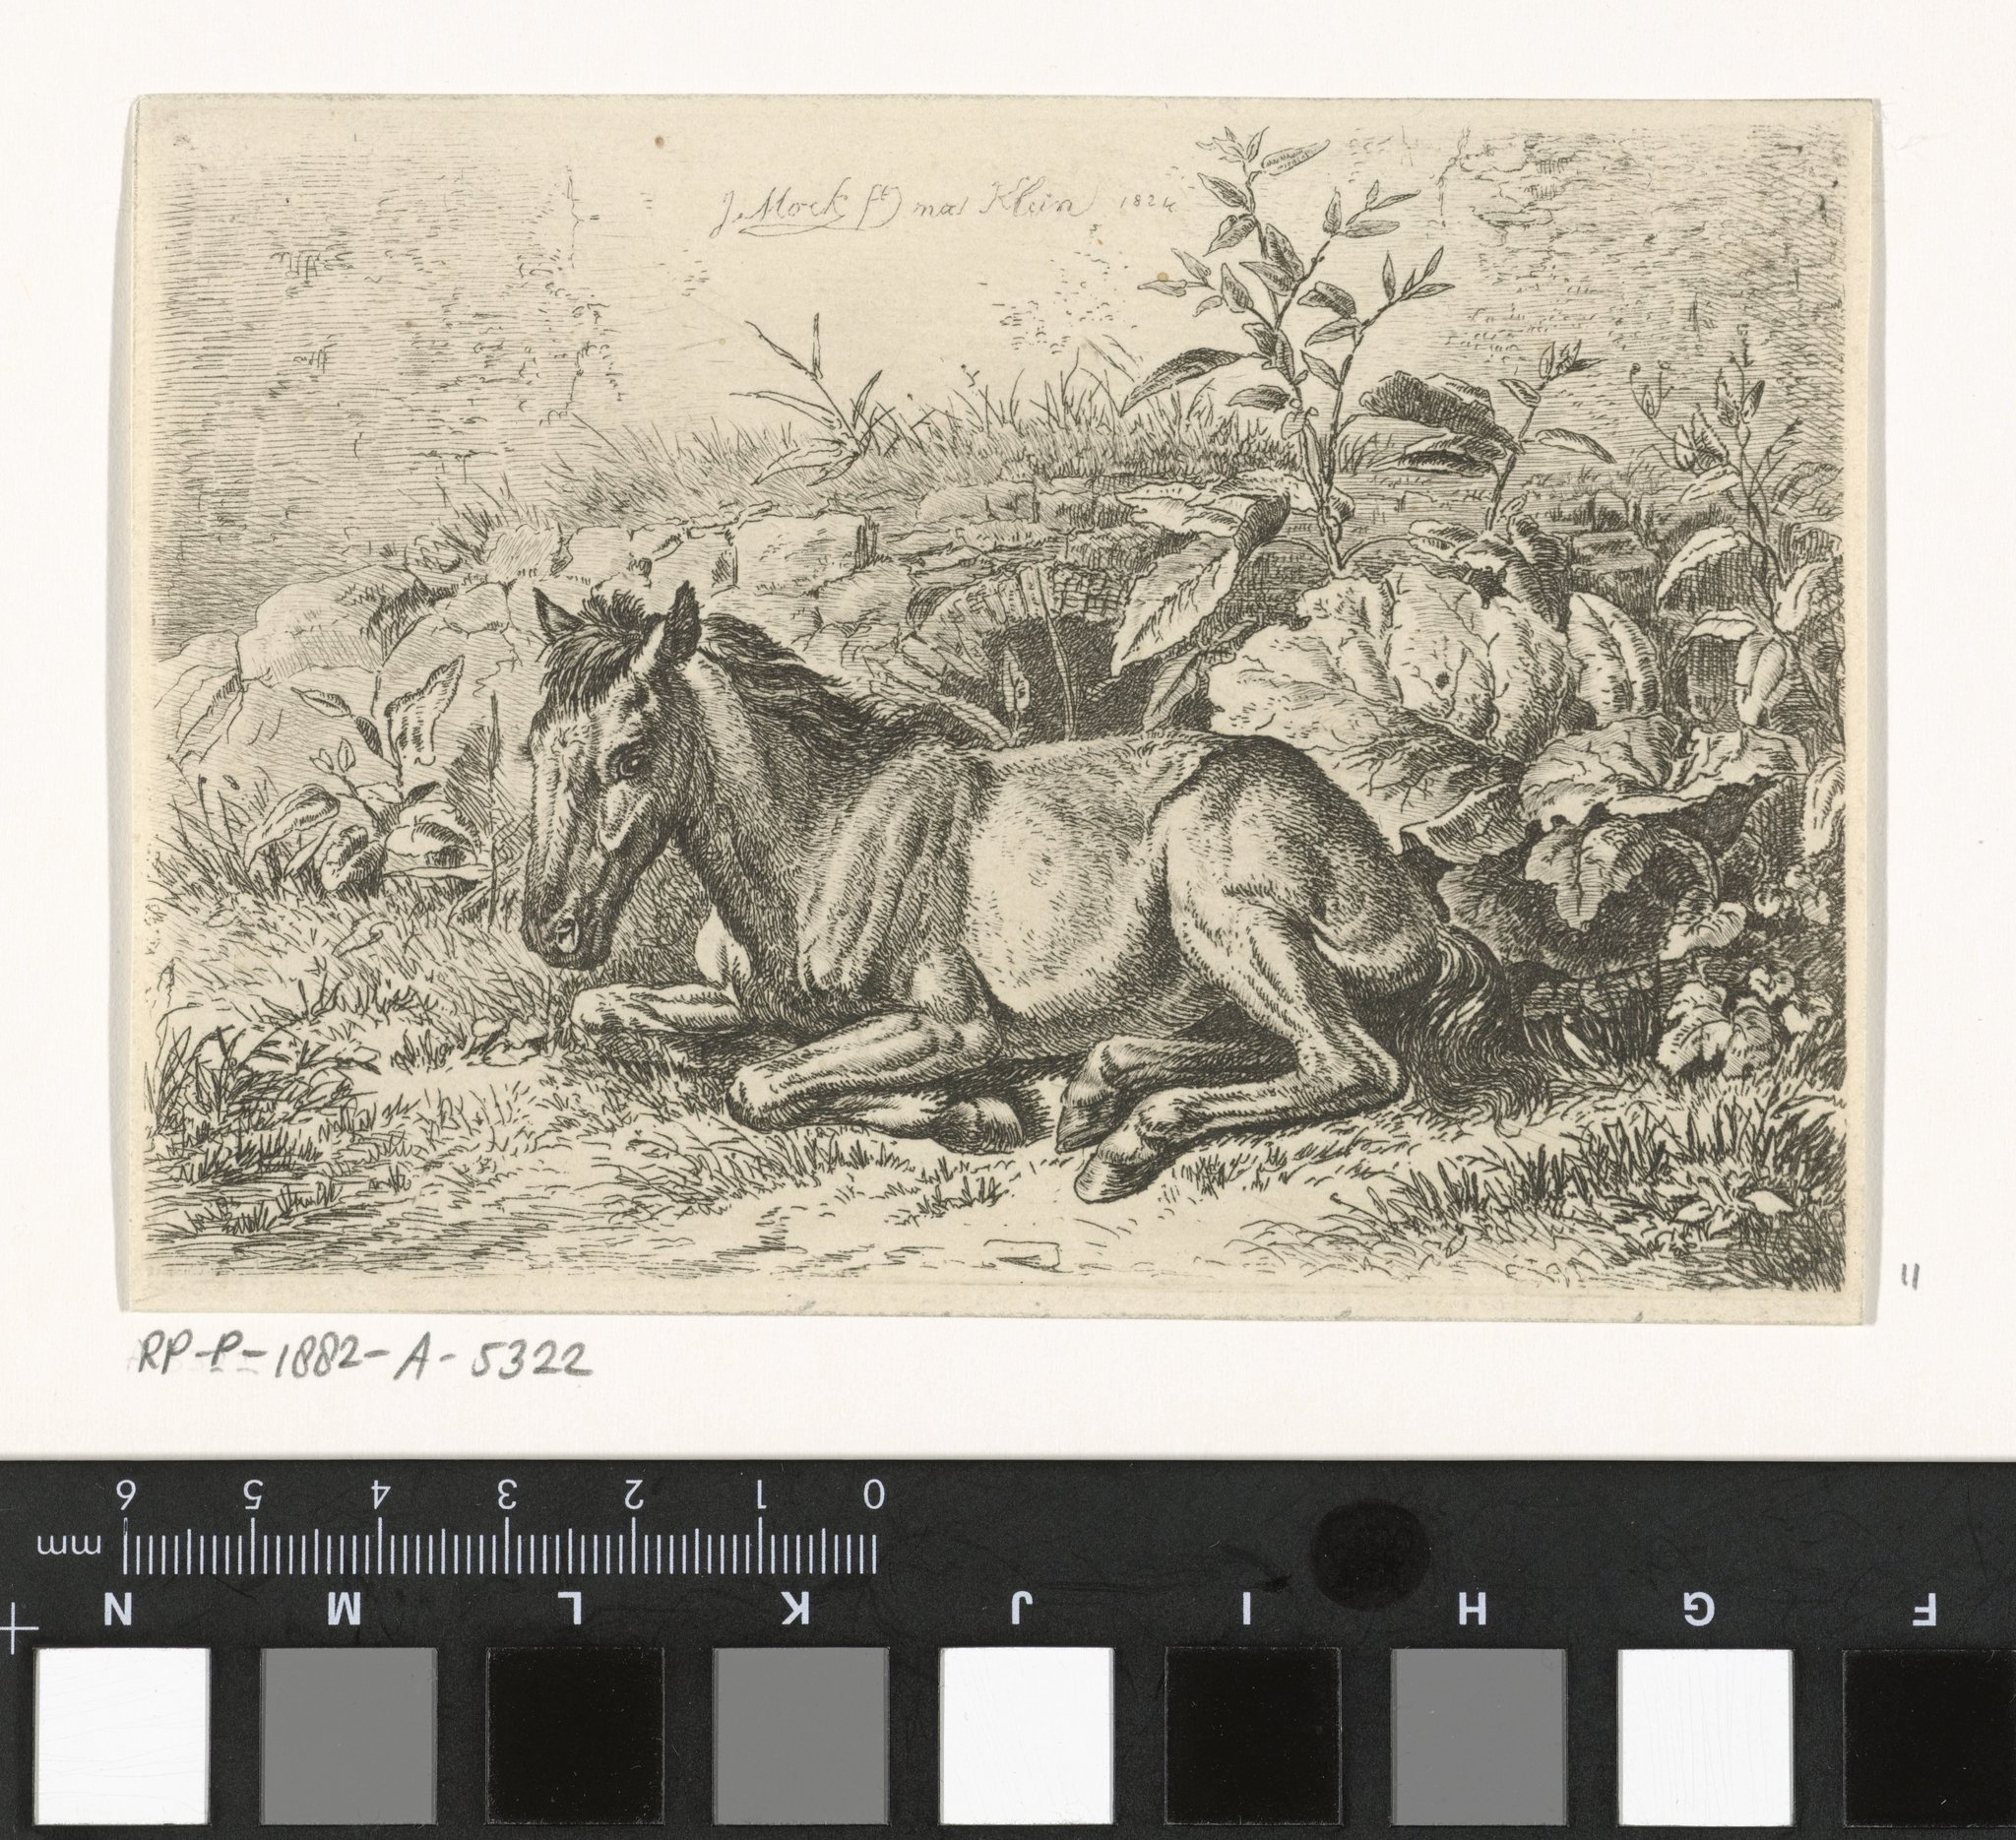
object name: print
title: Liggend paard voor enkele planten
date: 1824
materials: paper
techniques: drypoint, etching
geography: netherlands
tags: horses and kindred animals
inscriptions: collector's mark: Lugt 2228